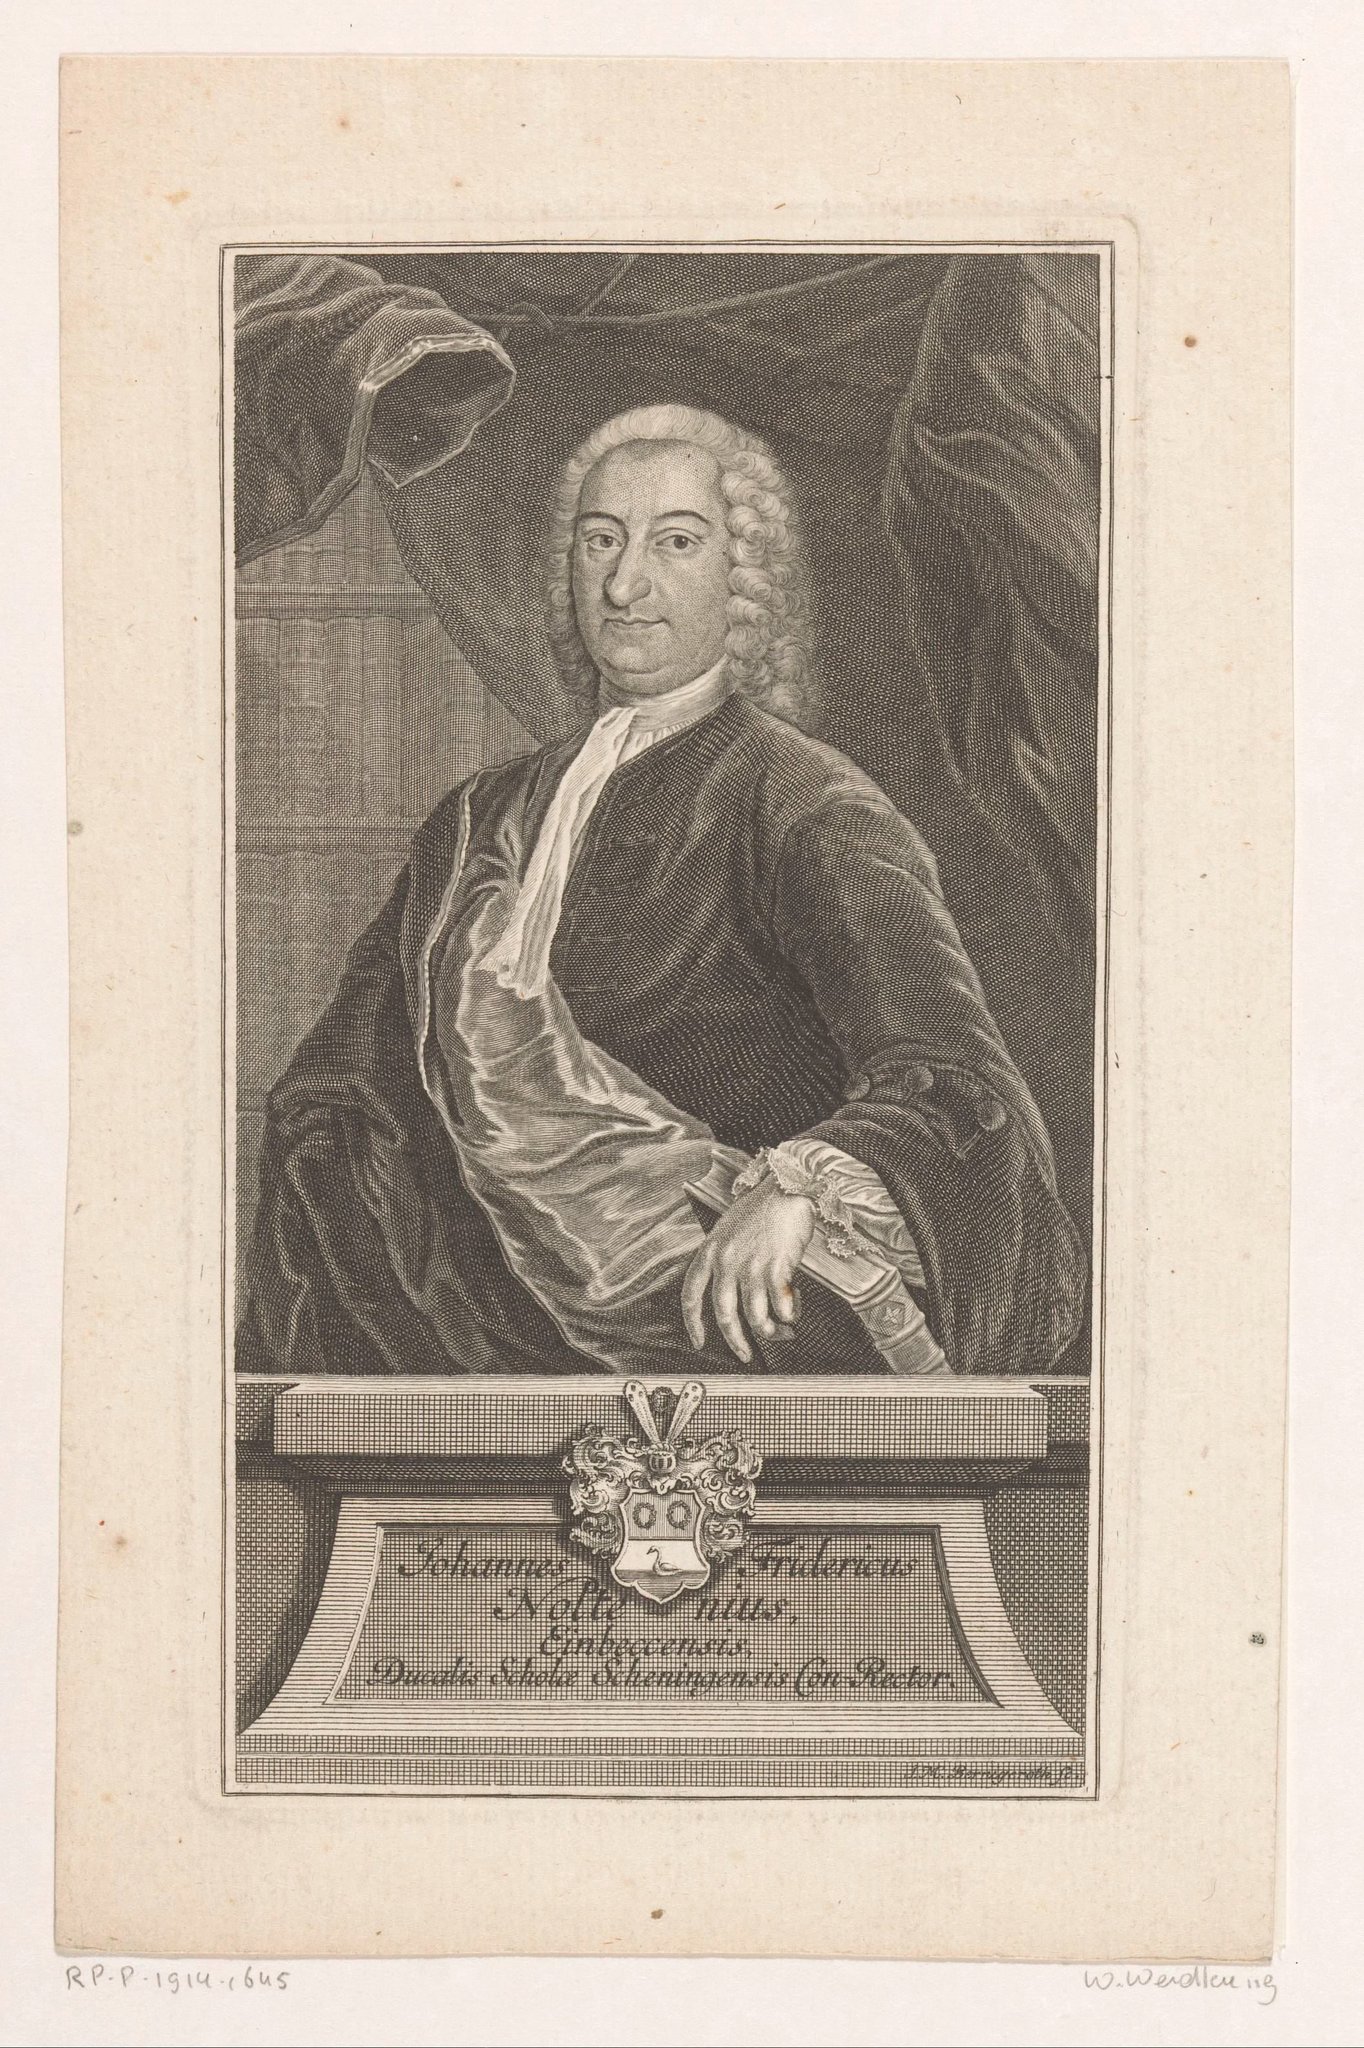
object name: print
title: Portret van Johann Friedrich Nolte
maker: johann martin bernigeroth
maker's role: print maker, publisher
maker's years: 1713-1767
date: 1755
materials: paper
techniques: engraving, etching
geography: leipzig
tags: bookshelves, historical persons, book, armorial bearing, heraldry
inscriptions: collector's mark: Lugt 2228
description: Prent ook gebruikt in: Zuverlässige Nachrichten von dem gegenwärtigen Zustande, Veränderung und Wachsthum der Wissenschaften. dl. 183. Leipzig: Johann Friedrich Gleditsch, 1755.